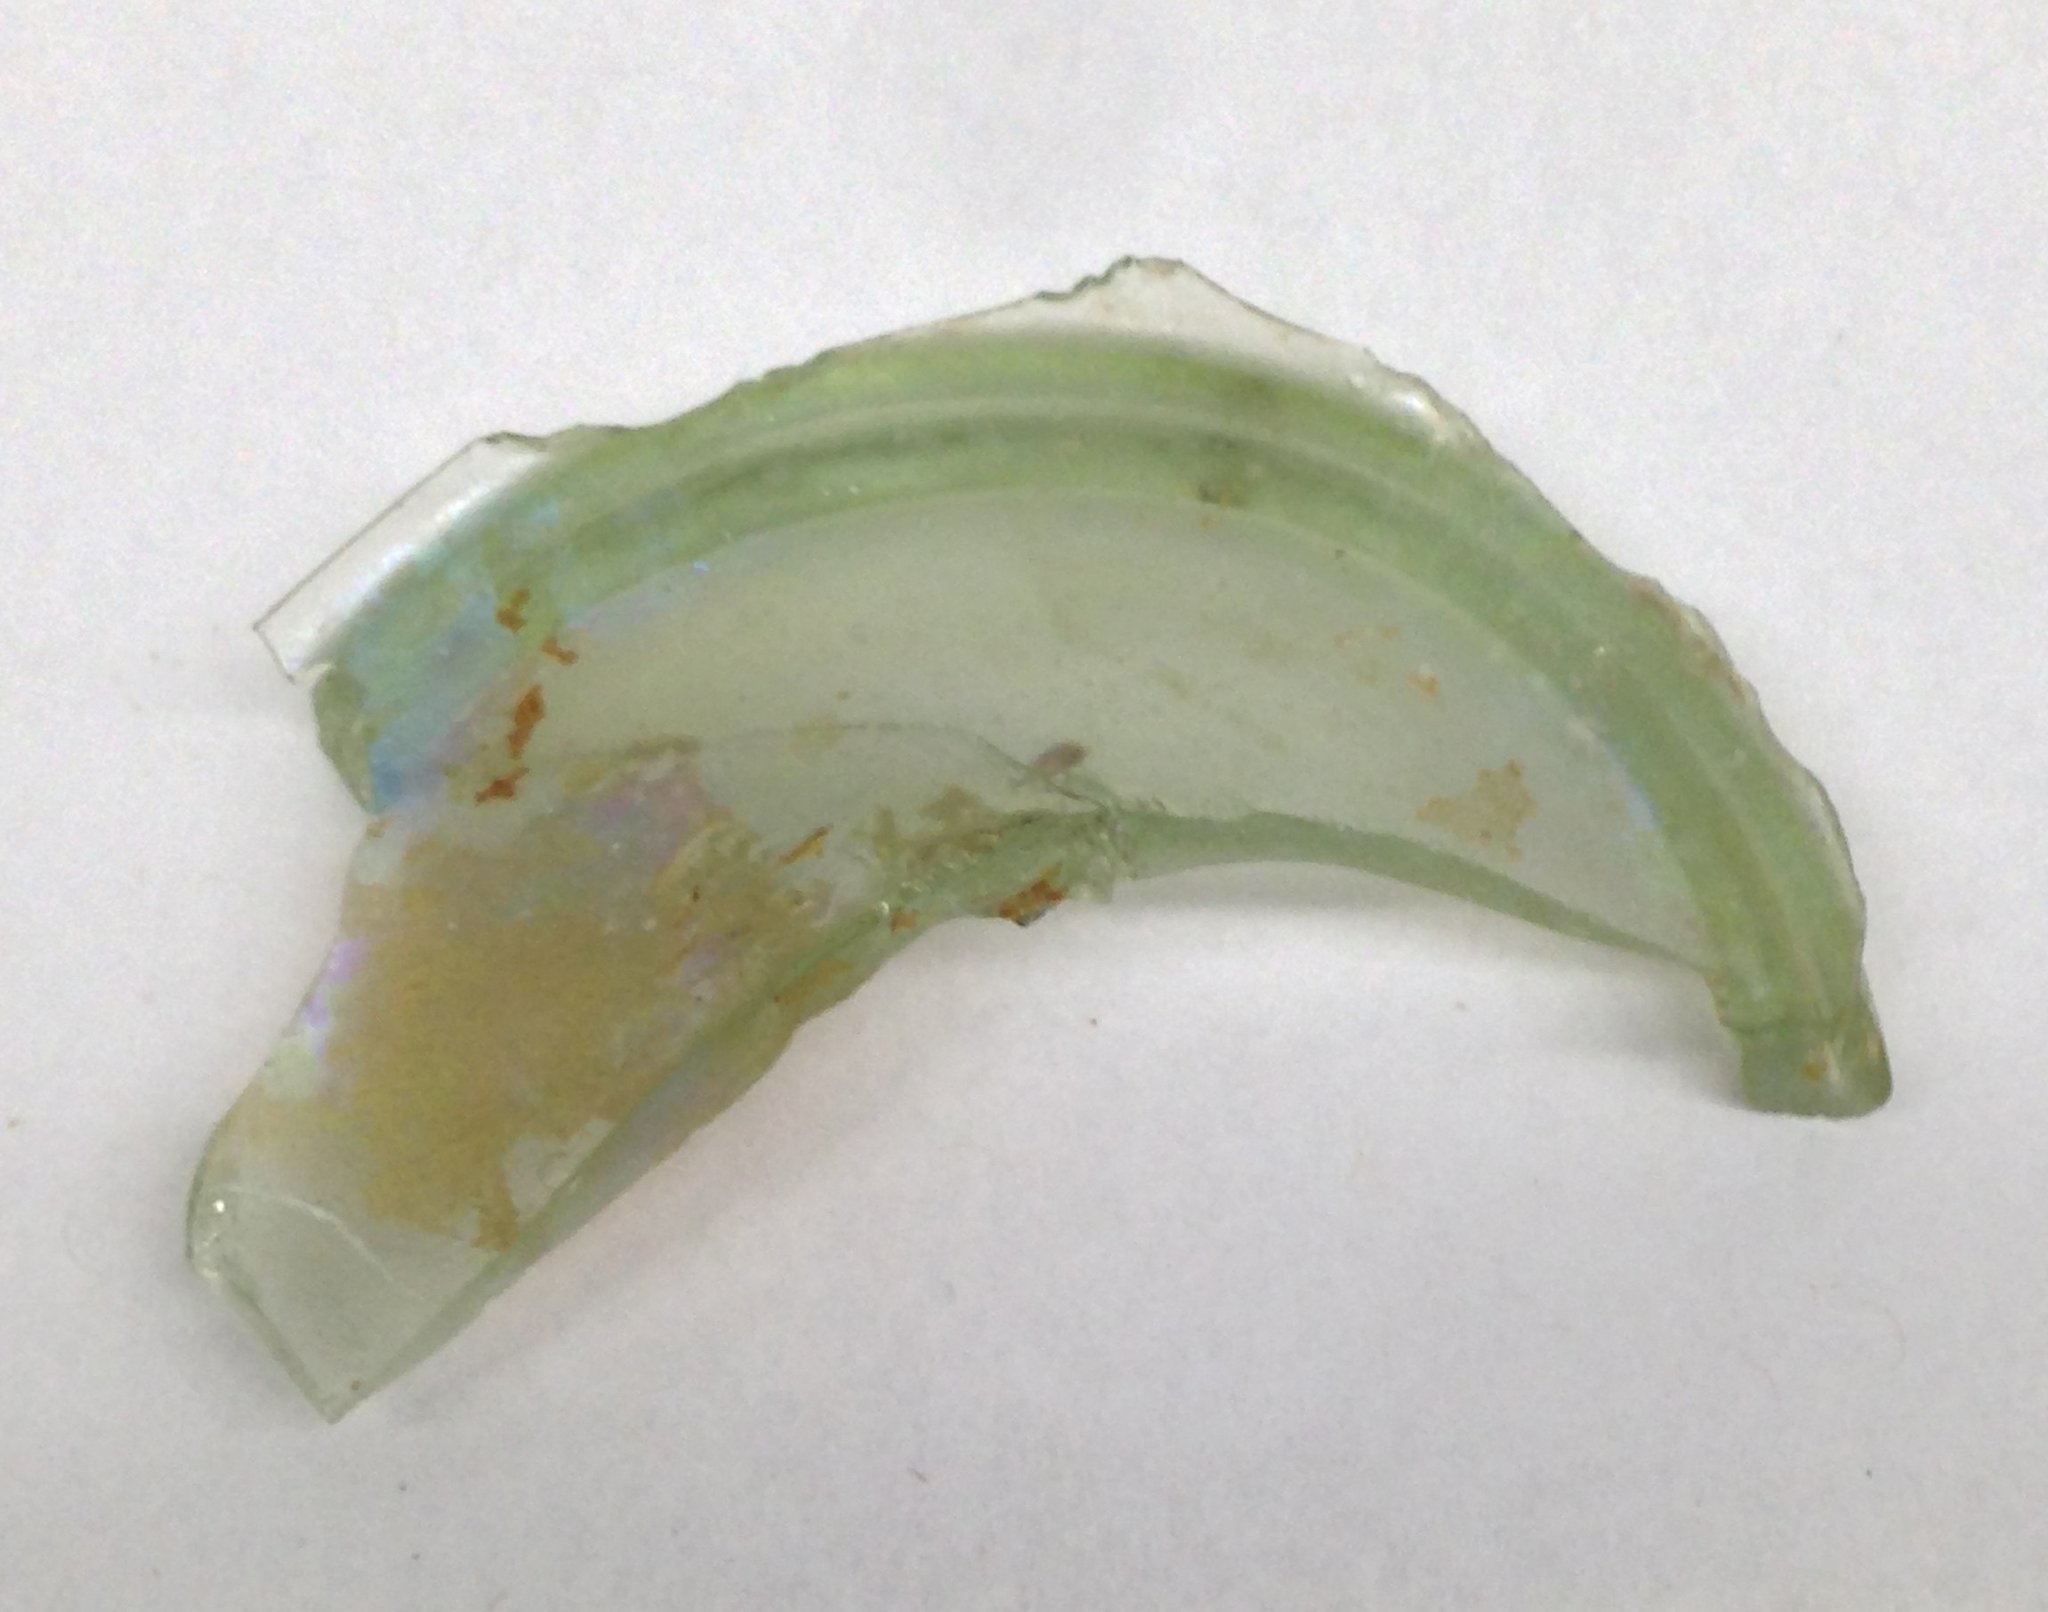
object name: fragment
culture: european or middle eastern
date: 1150-1250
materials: ceramic, glass